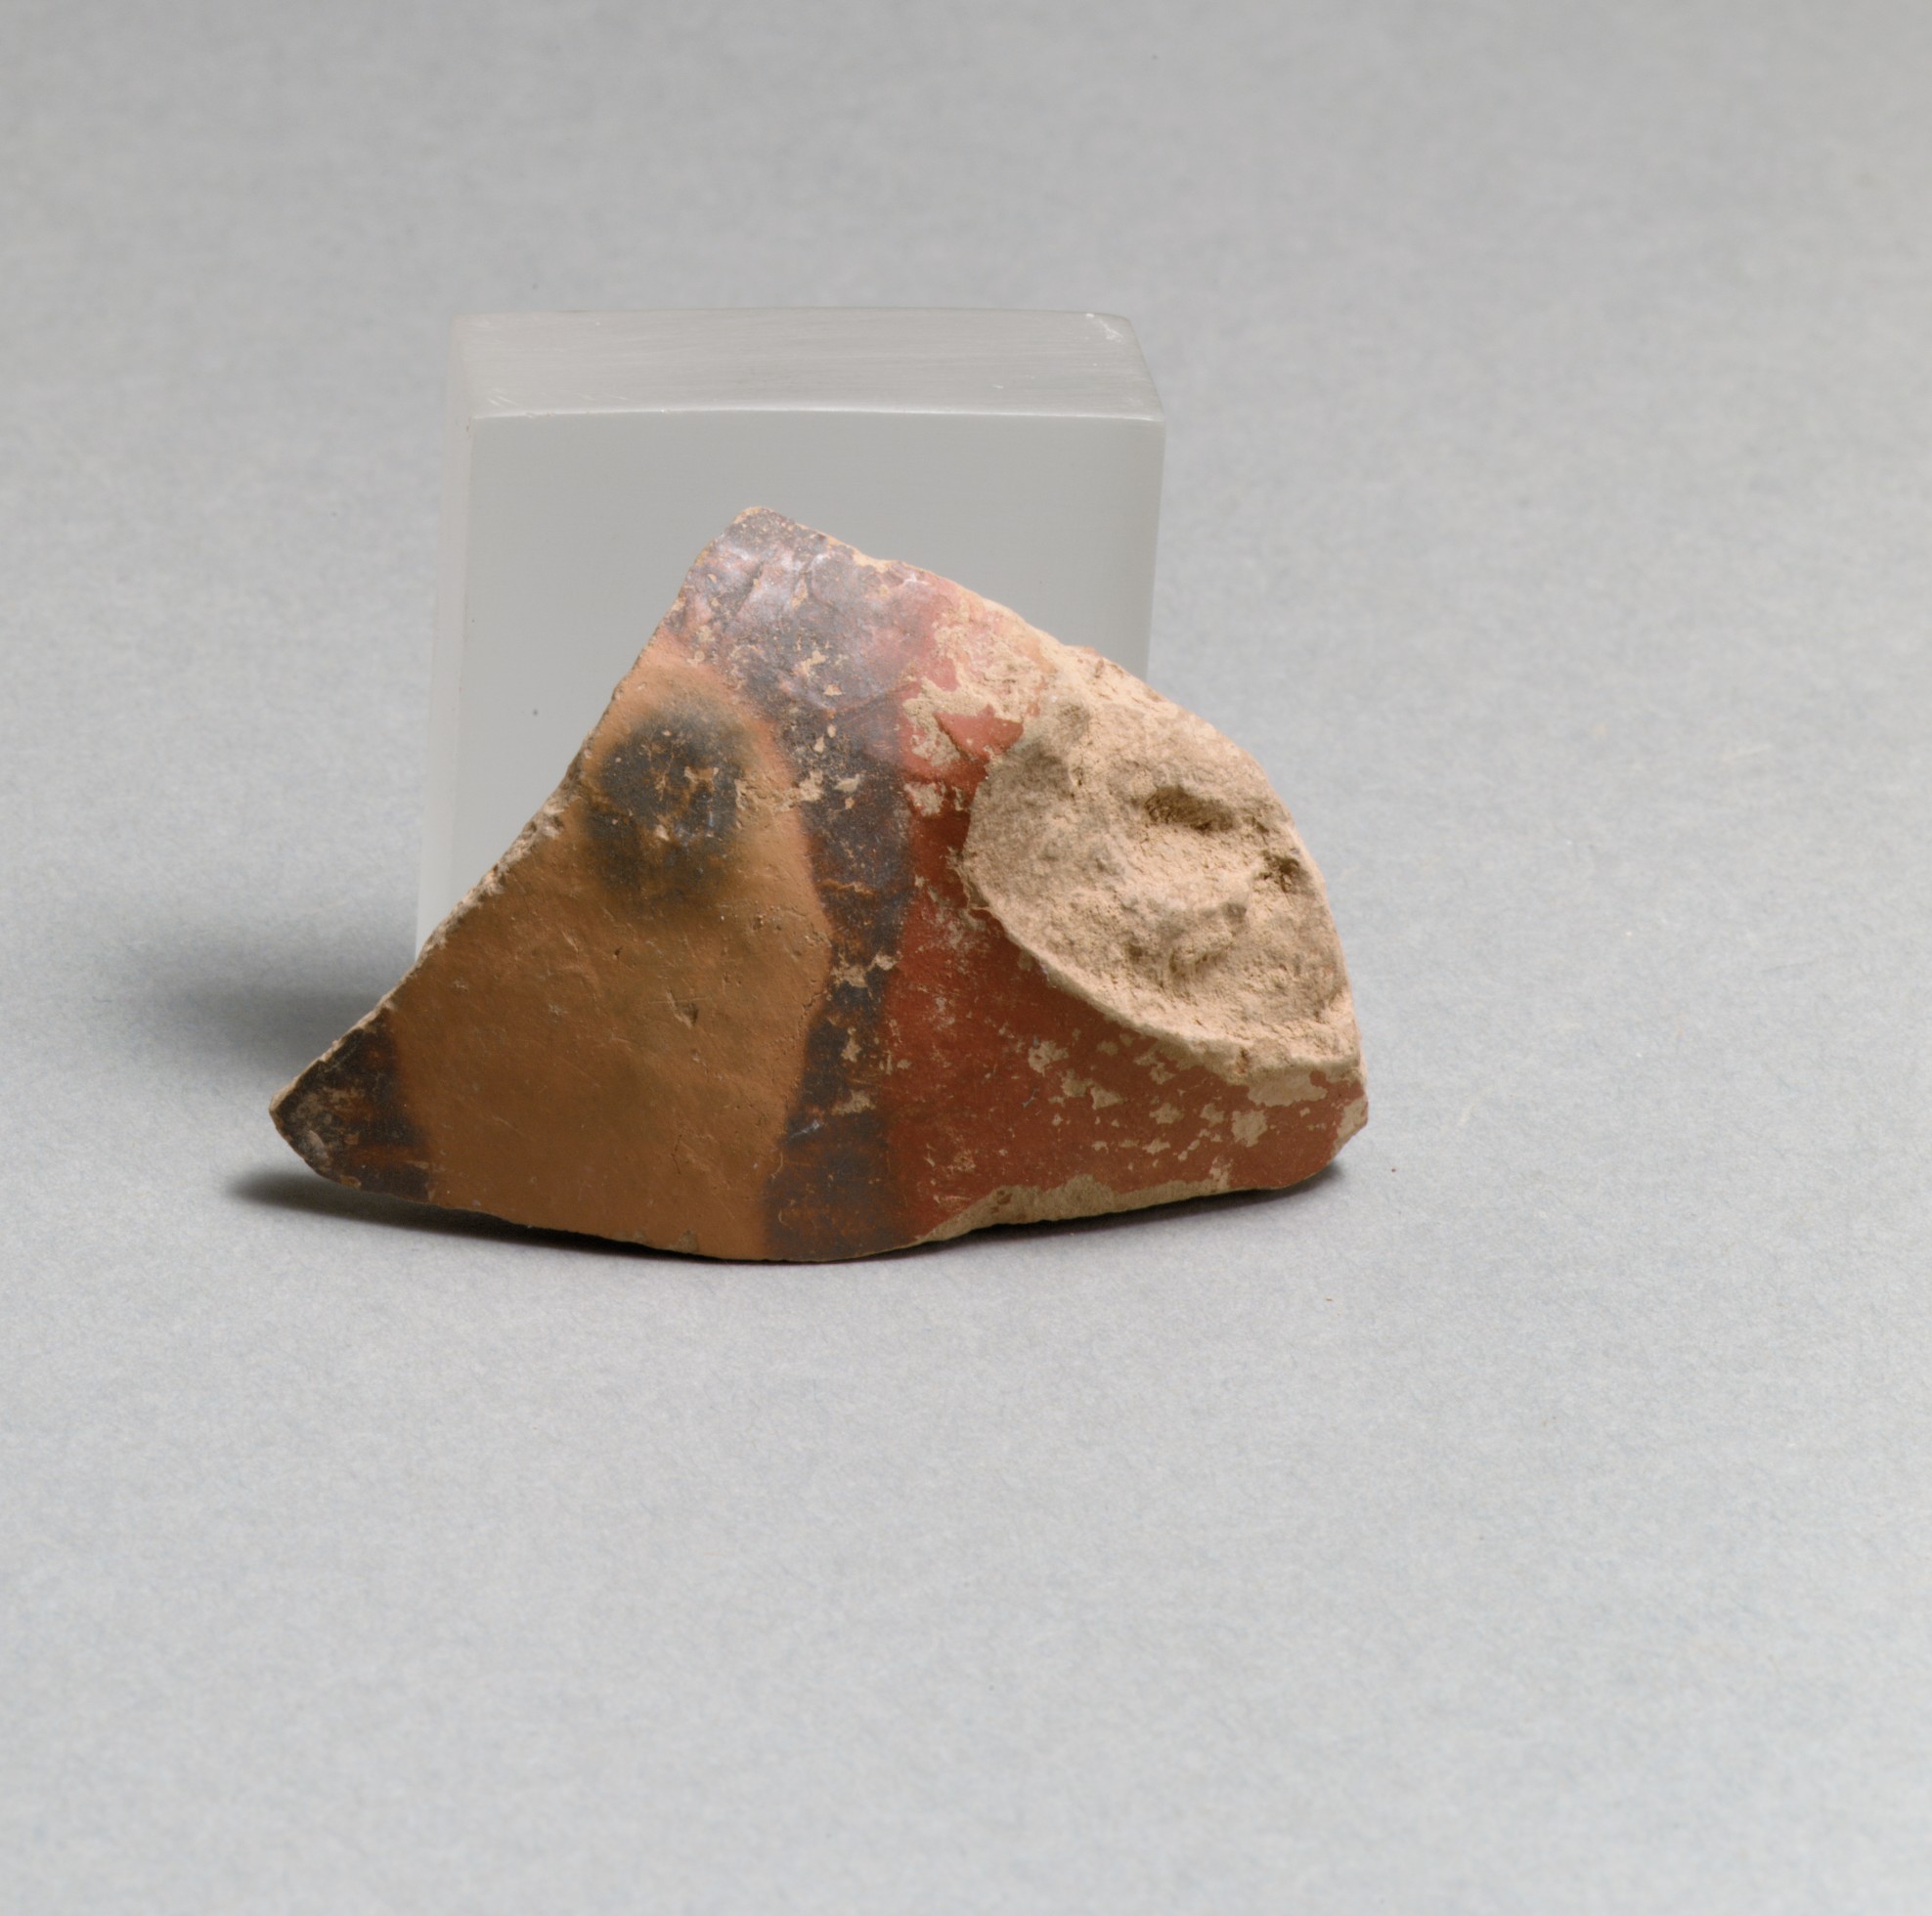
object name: vase fragment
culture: minoan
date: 2600-2000 BCE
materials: terracotta